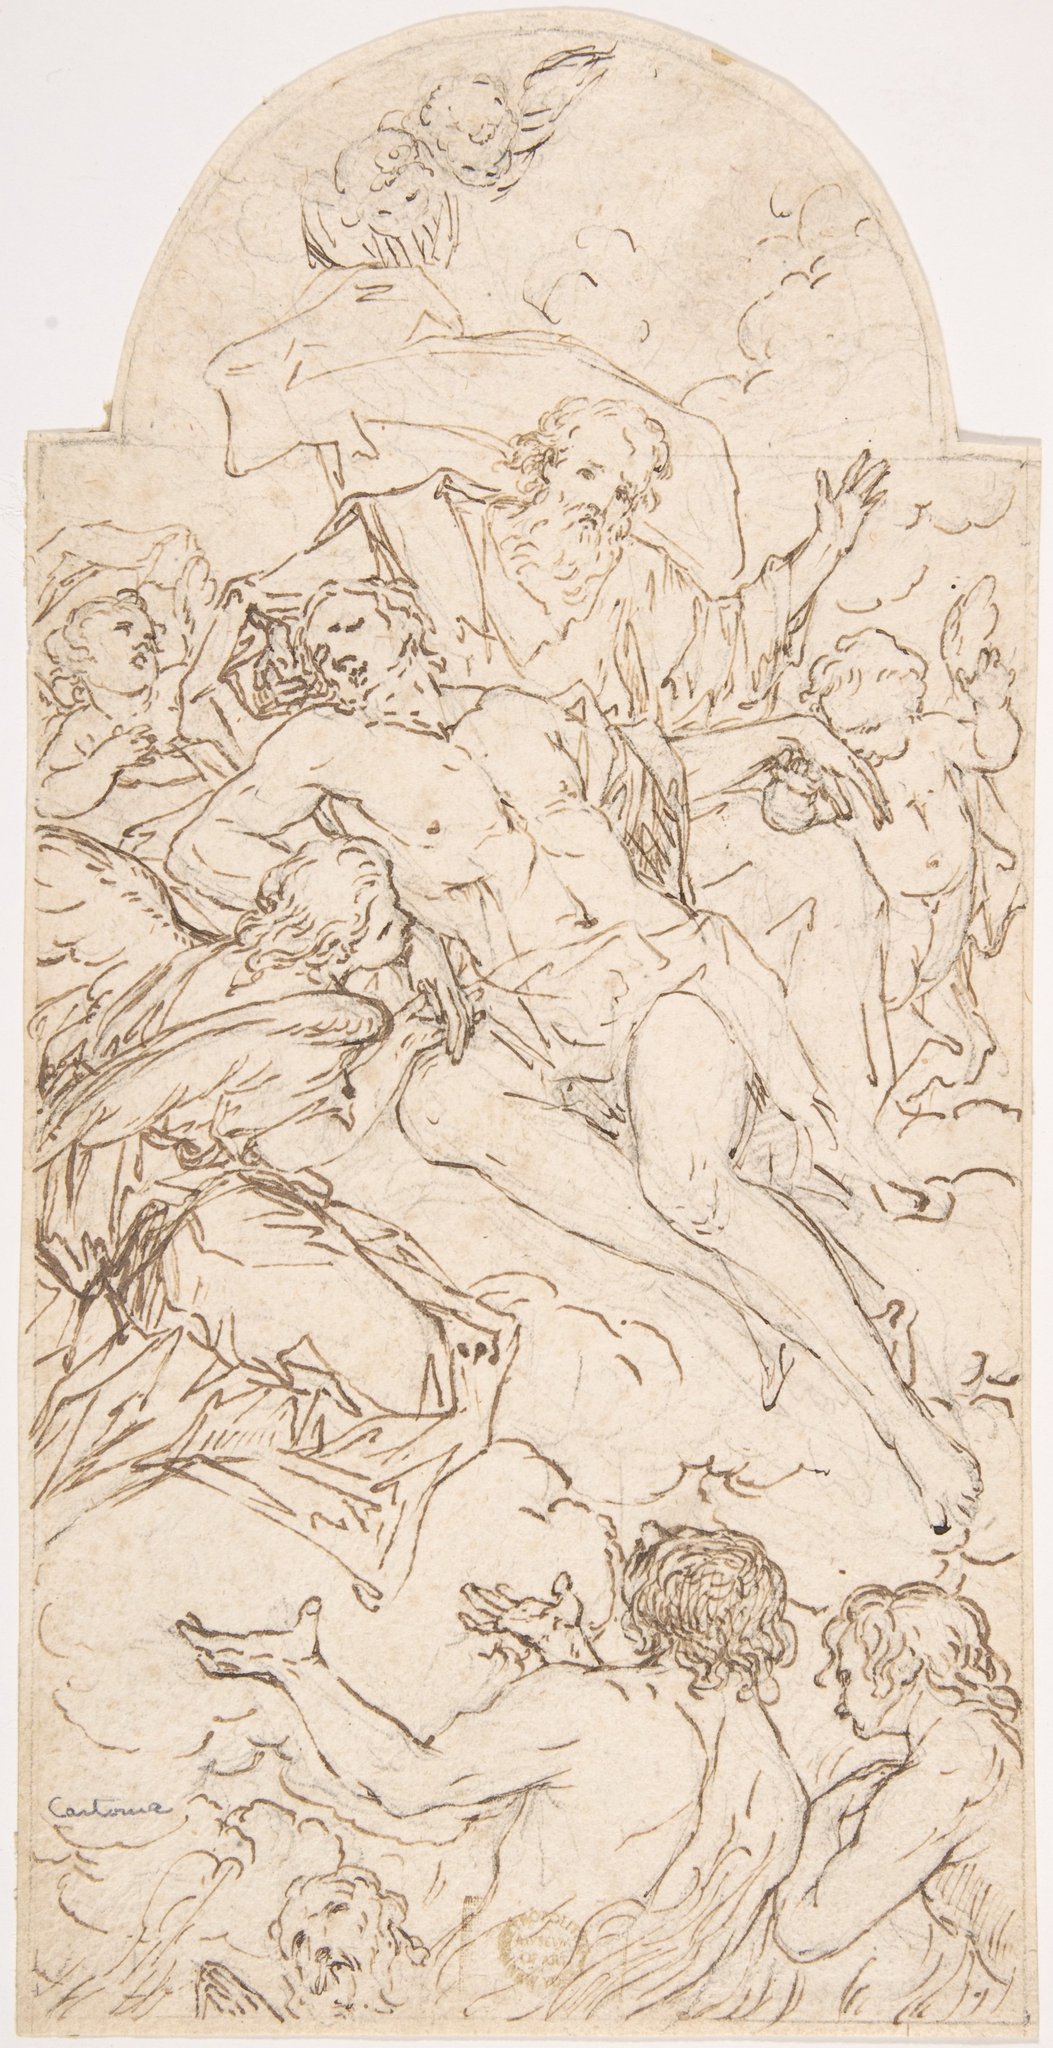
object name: drawing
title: Death of Christ Redeeming Souls from Purgatory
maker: anonymous, italian, roman-bolognese, 17th century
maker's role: artist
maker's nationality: italian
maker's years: 1600-1700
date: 1601-1700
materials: chalk, ink, paper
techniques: pen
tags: men,angels,christ,death